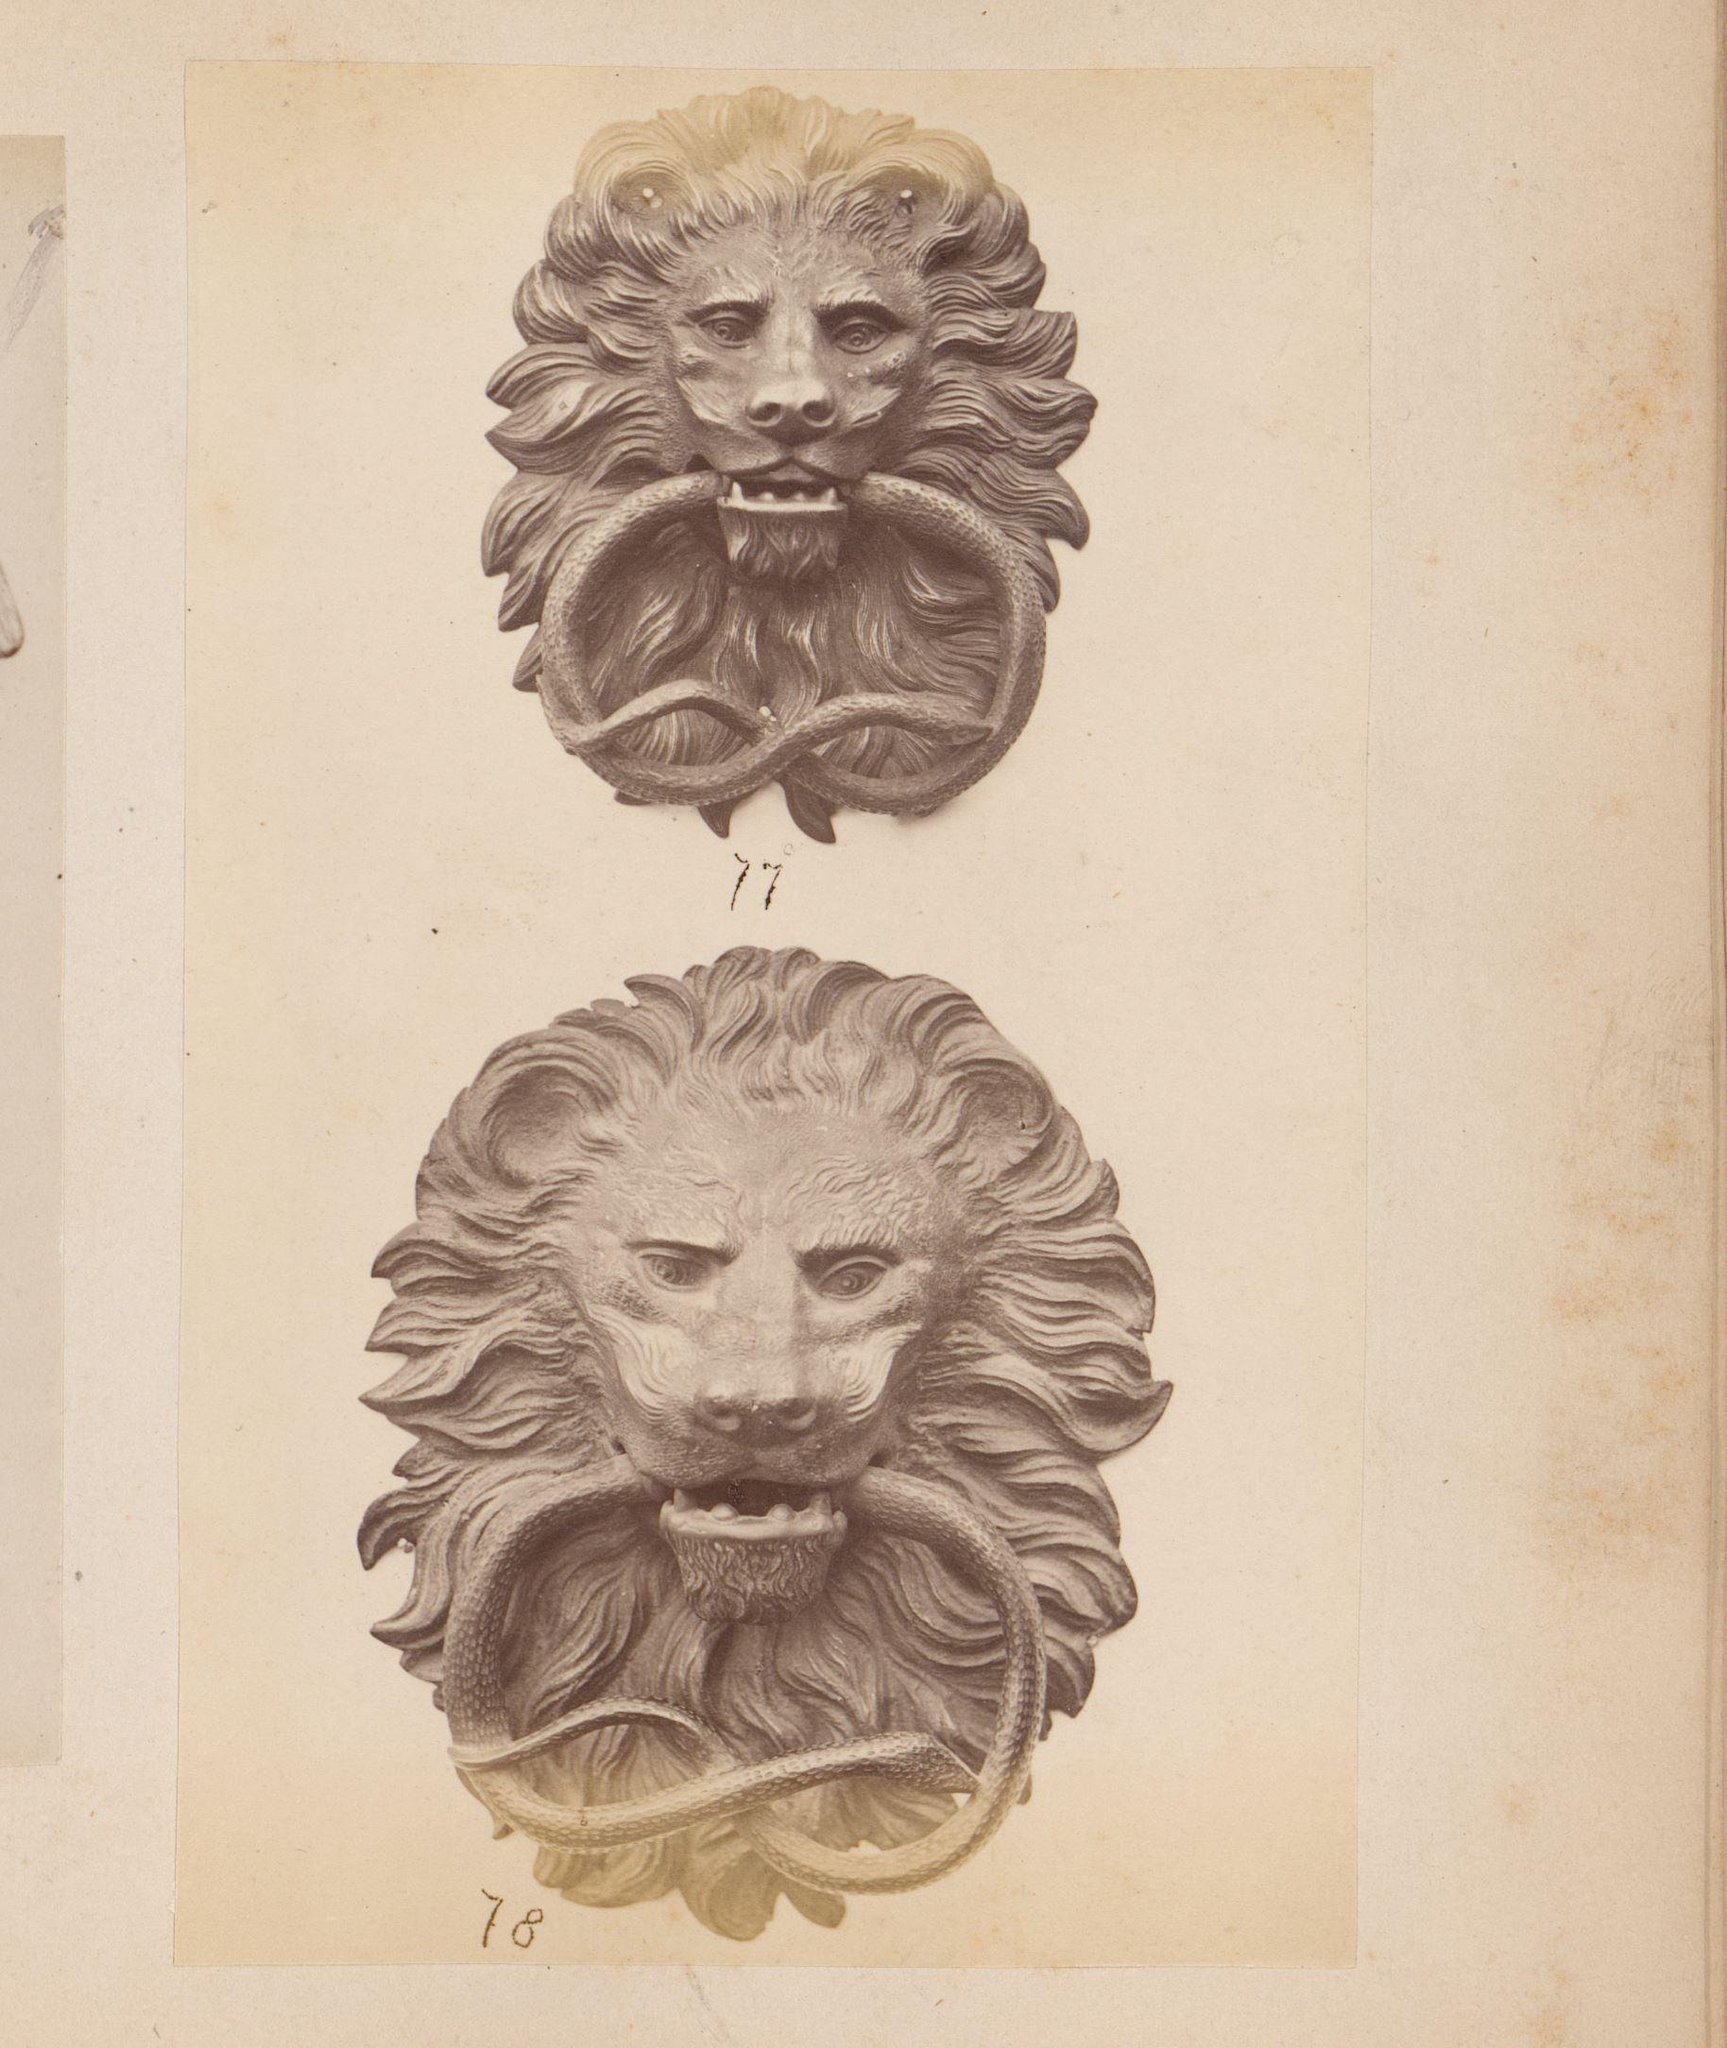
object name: page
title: Metalen deurkloppers in de vorm van leeuwen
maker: Anonymous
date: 1860-1885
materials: photographic support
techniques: albumen print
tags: lion's head ~ ornament, door-knocker, doorbell